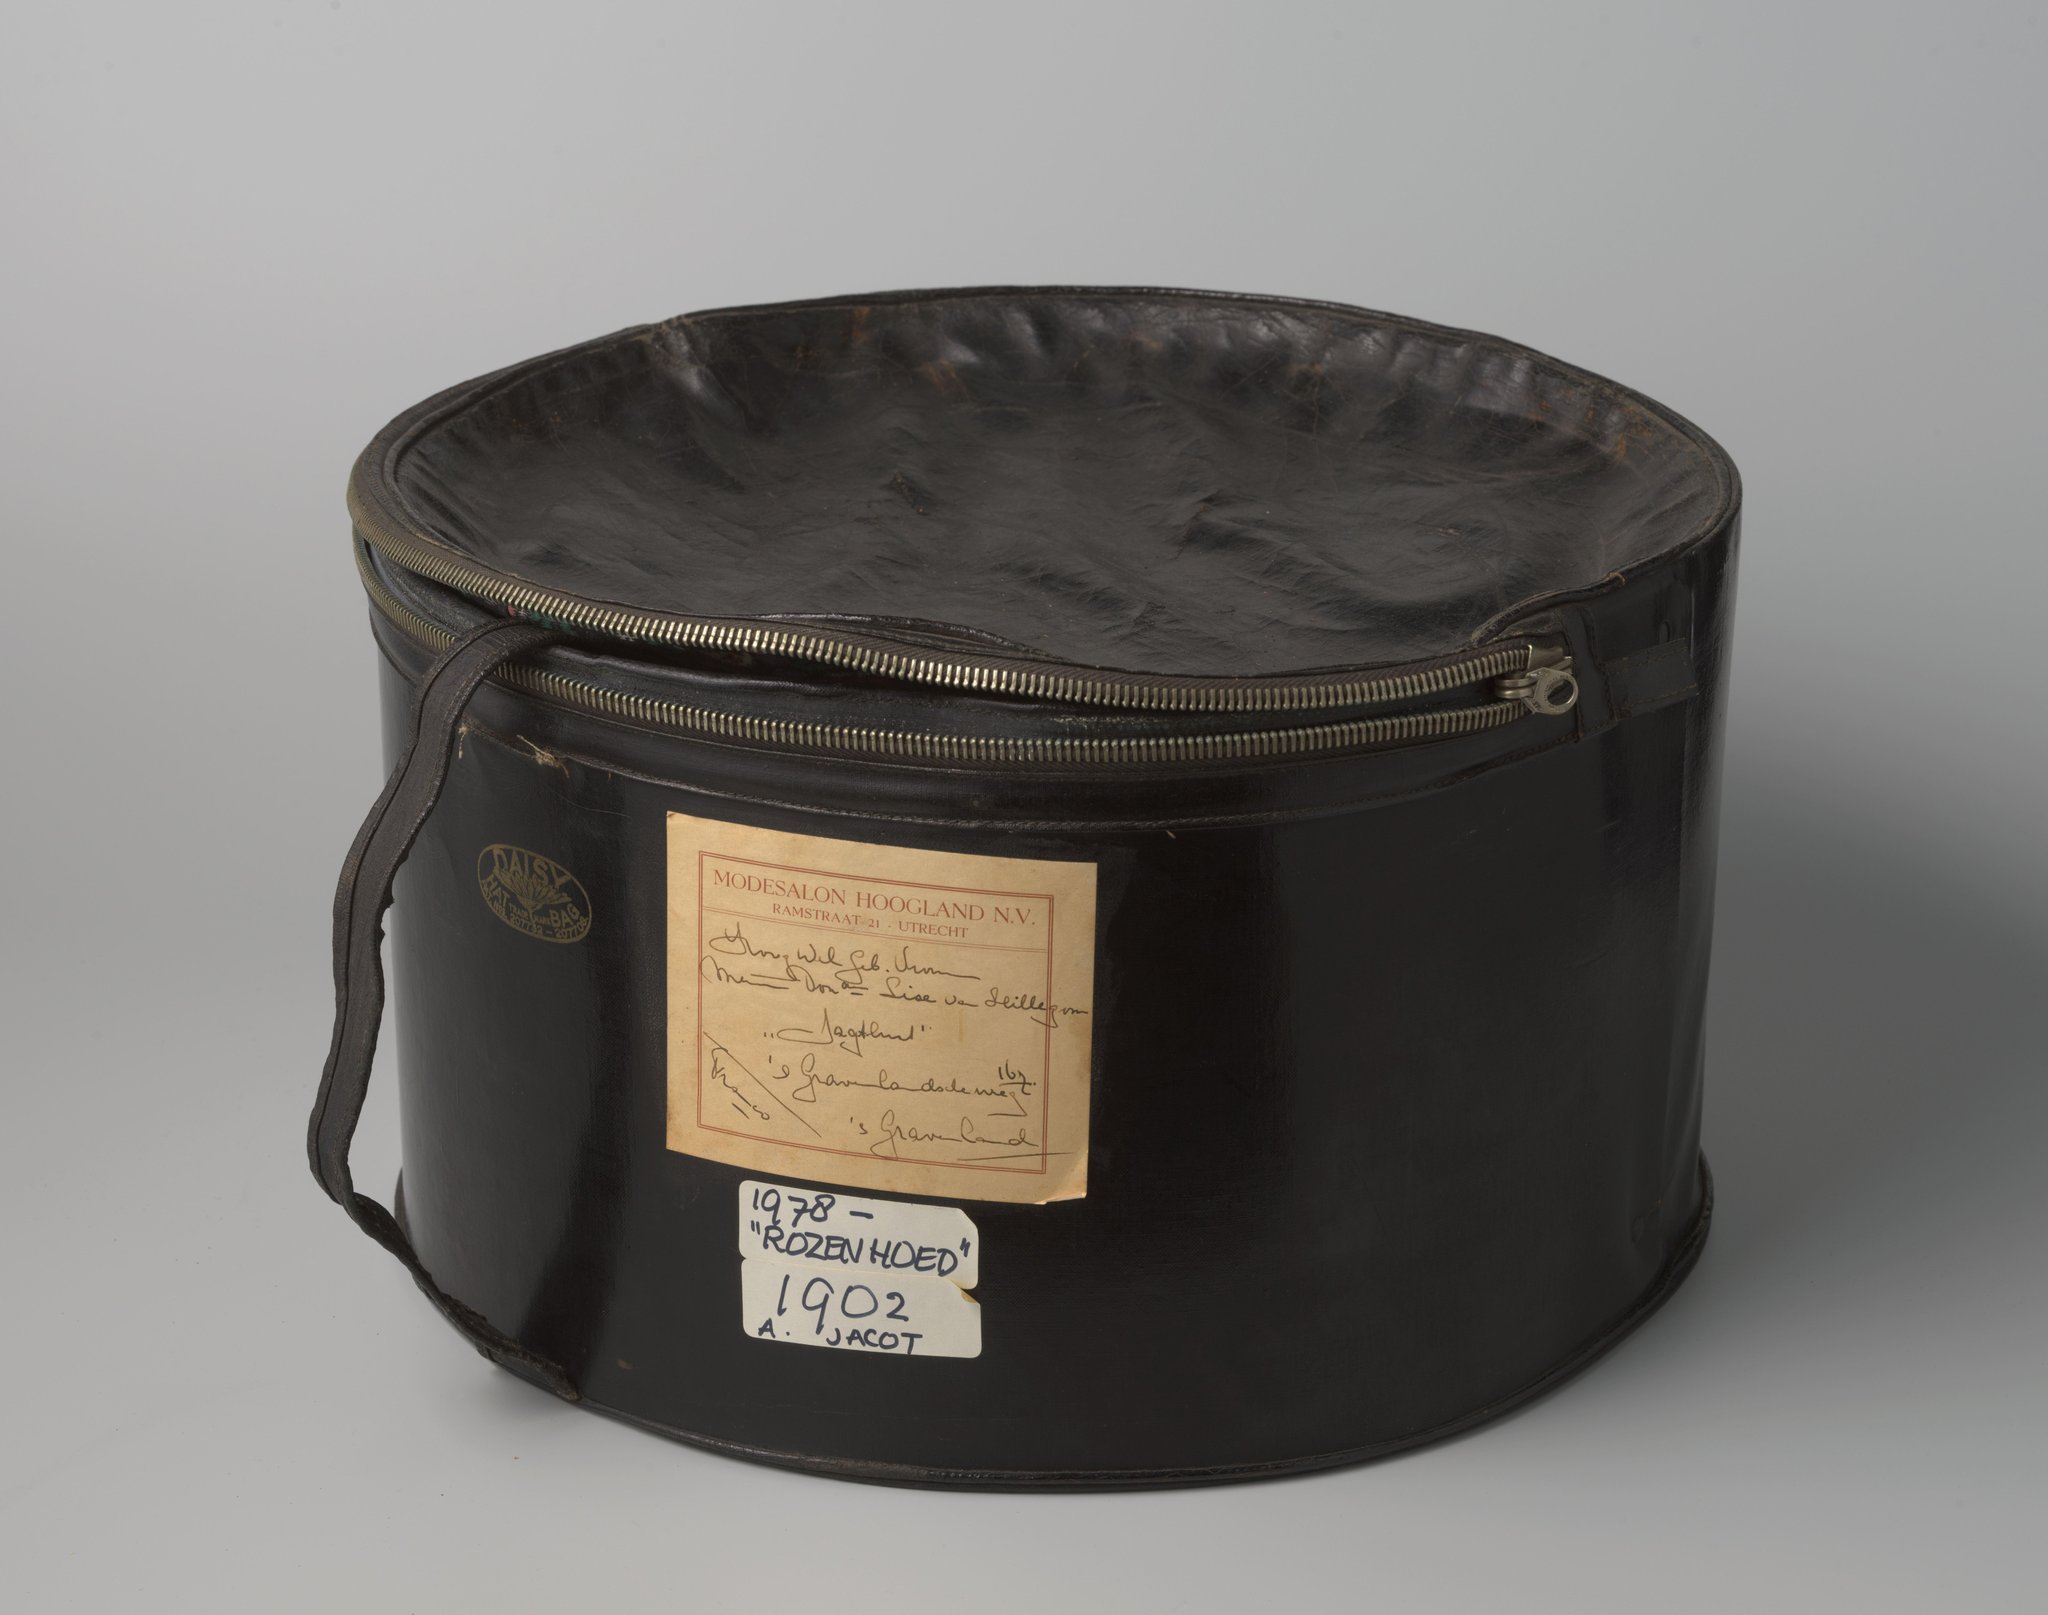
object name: womenswear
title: Hoedendoos, rond, van zwart gelakt zeildoek met ritssluiting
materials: textile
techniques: lacquer, printing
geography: utrecht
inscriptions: company name, company name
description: Hoedendoos, rond, van zwart gelakt zeildoek met ritssluiting. De doos is gevoerd met met bloemen bedrukte zwarte kunstzijde. Oorspronkelijk een hengsel aan de zijkant van de doos; deze is kapot.